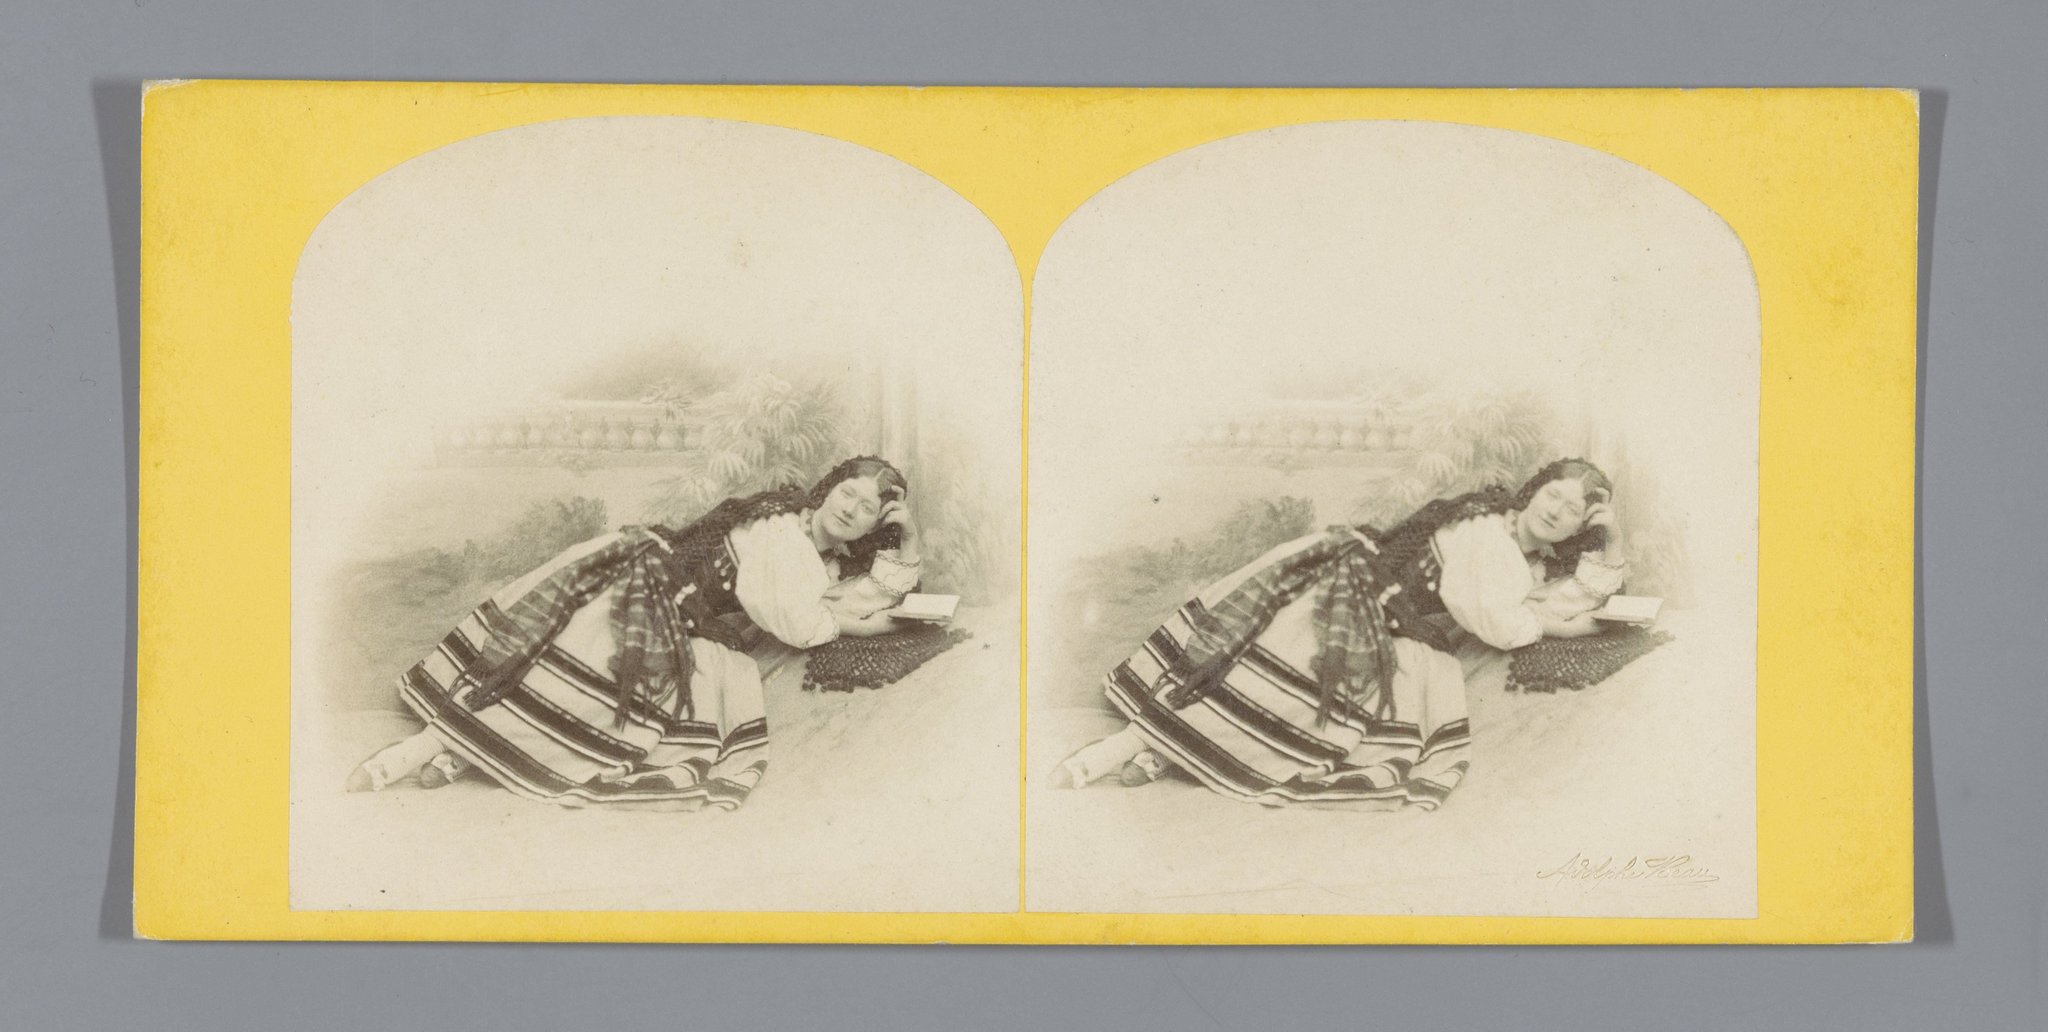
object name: stereograph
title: Kate Terry liggend met een boek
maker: adolphe beau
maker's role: fotograaf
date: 1850-1880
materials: cardboard, photographic support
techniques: albumen print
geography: europe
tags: portrait of actor, actress, europe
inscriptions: inscription: ‘Kate Terry’, name: ‘Adolphe Beau’